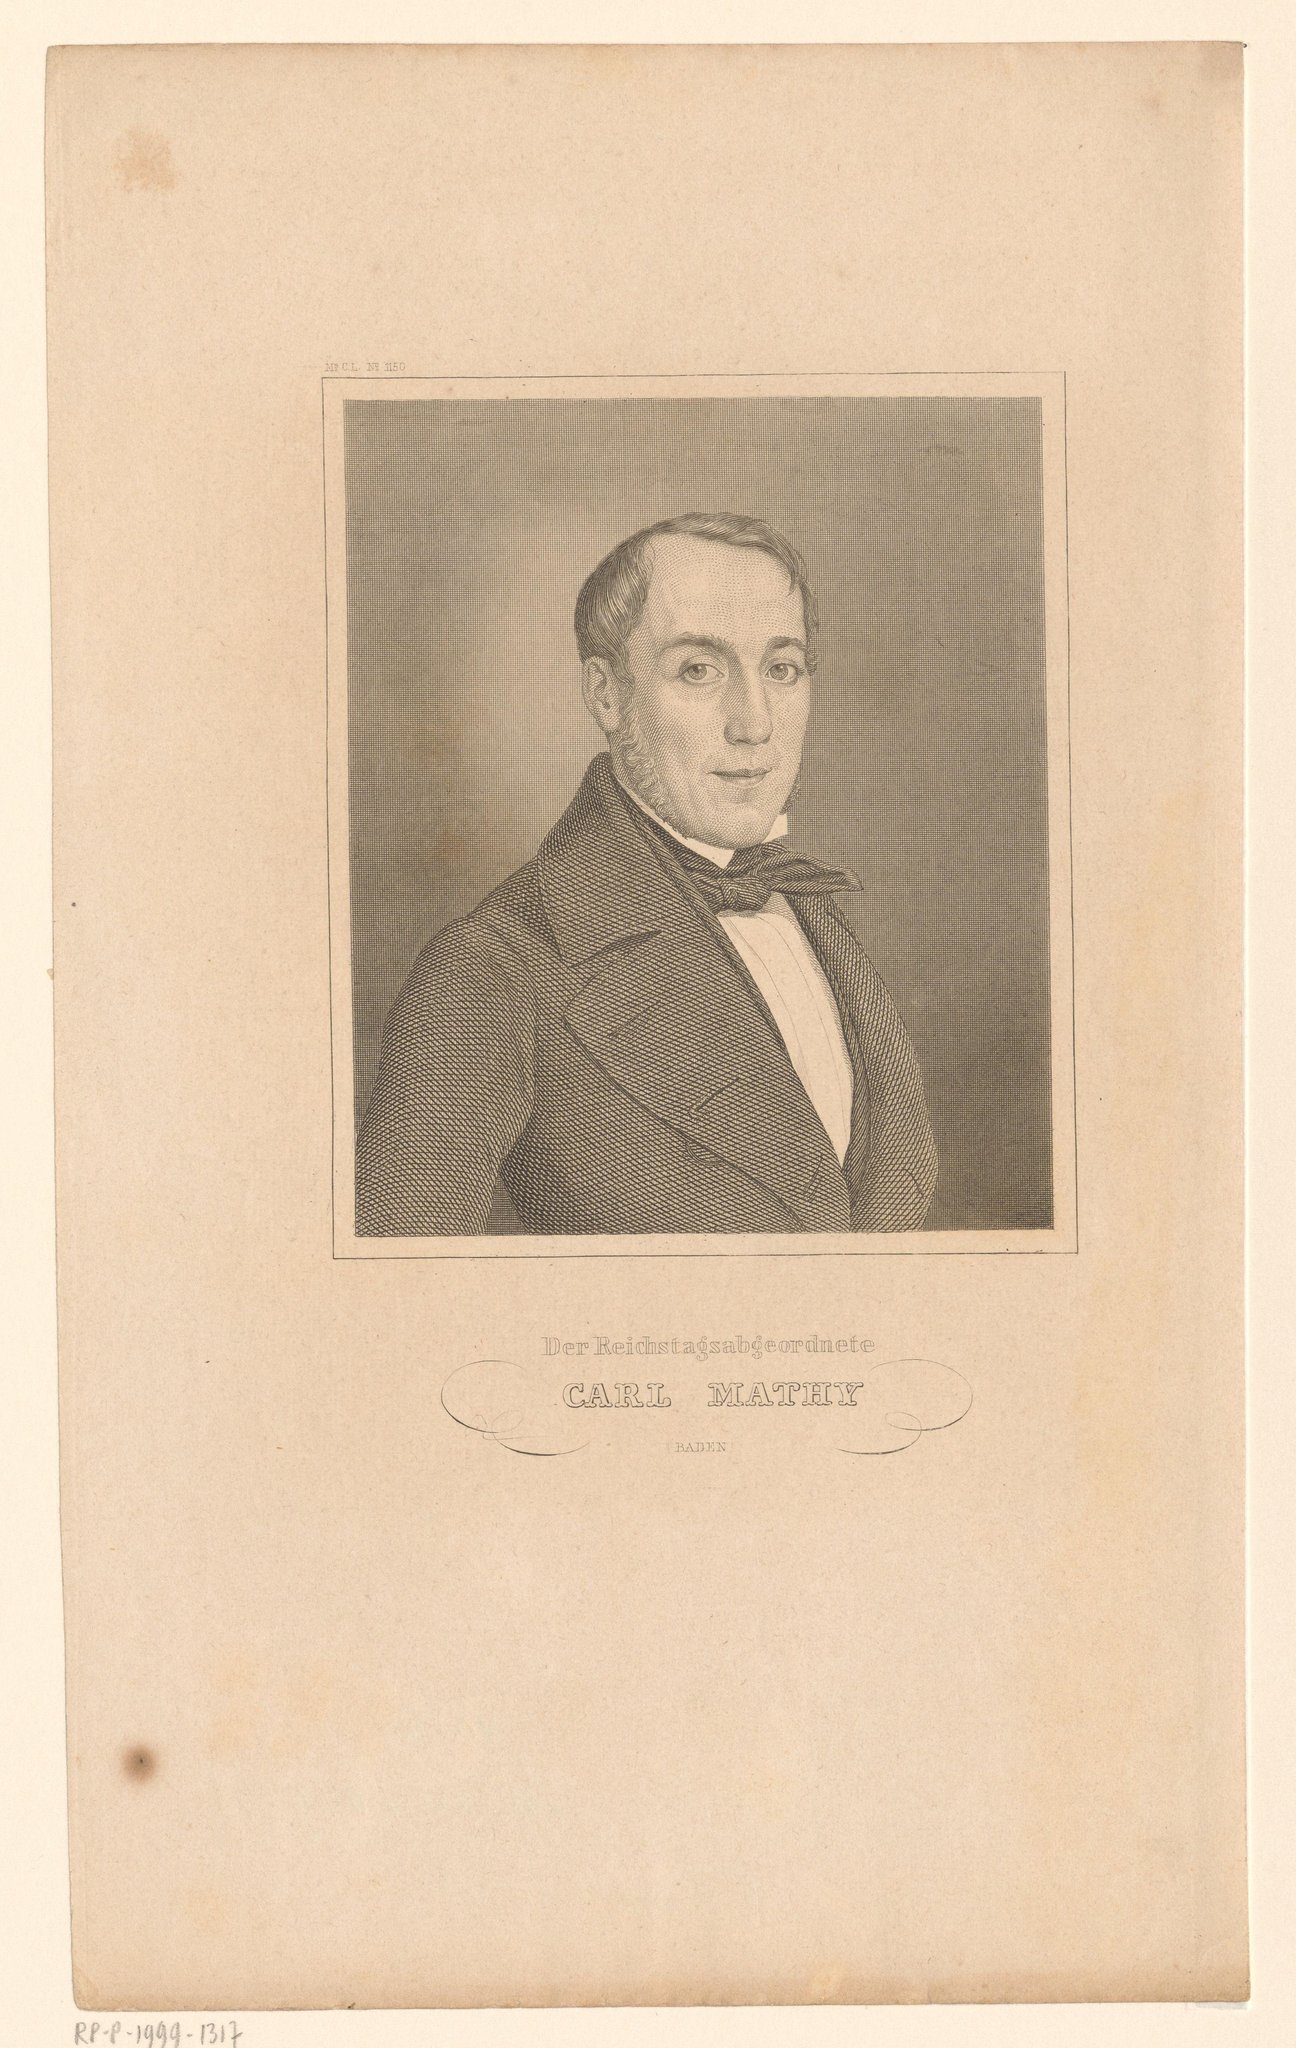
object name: print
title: Portret van Karl Mathy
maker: Anonymous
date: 1839-1855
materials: paper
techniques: engraving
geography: germany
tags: historical persons, politician, e.g. party leader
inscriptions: collector's mark: Lugt 2760, collector's mark: Lugt 2228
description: Prent waarschijnlijk uit: Meyer, Joseph. Das große Conversations-Lexikon für die gebildeten Stände. 52 dln. Hildburghausen: Bibliographisches Institut, [1839-1855].